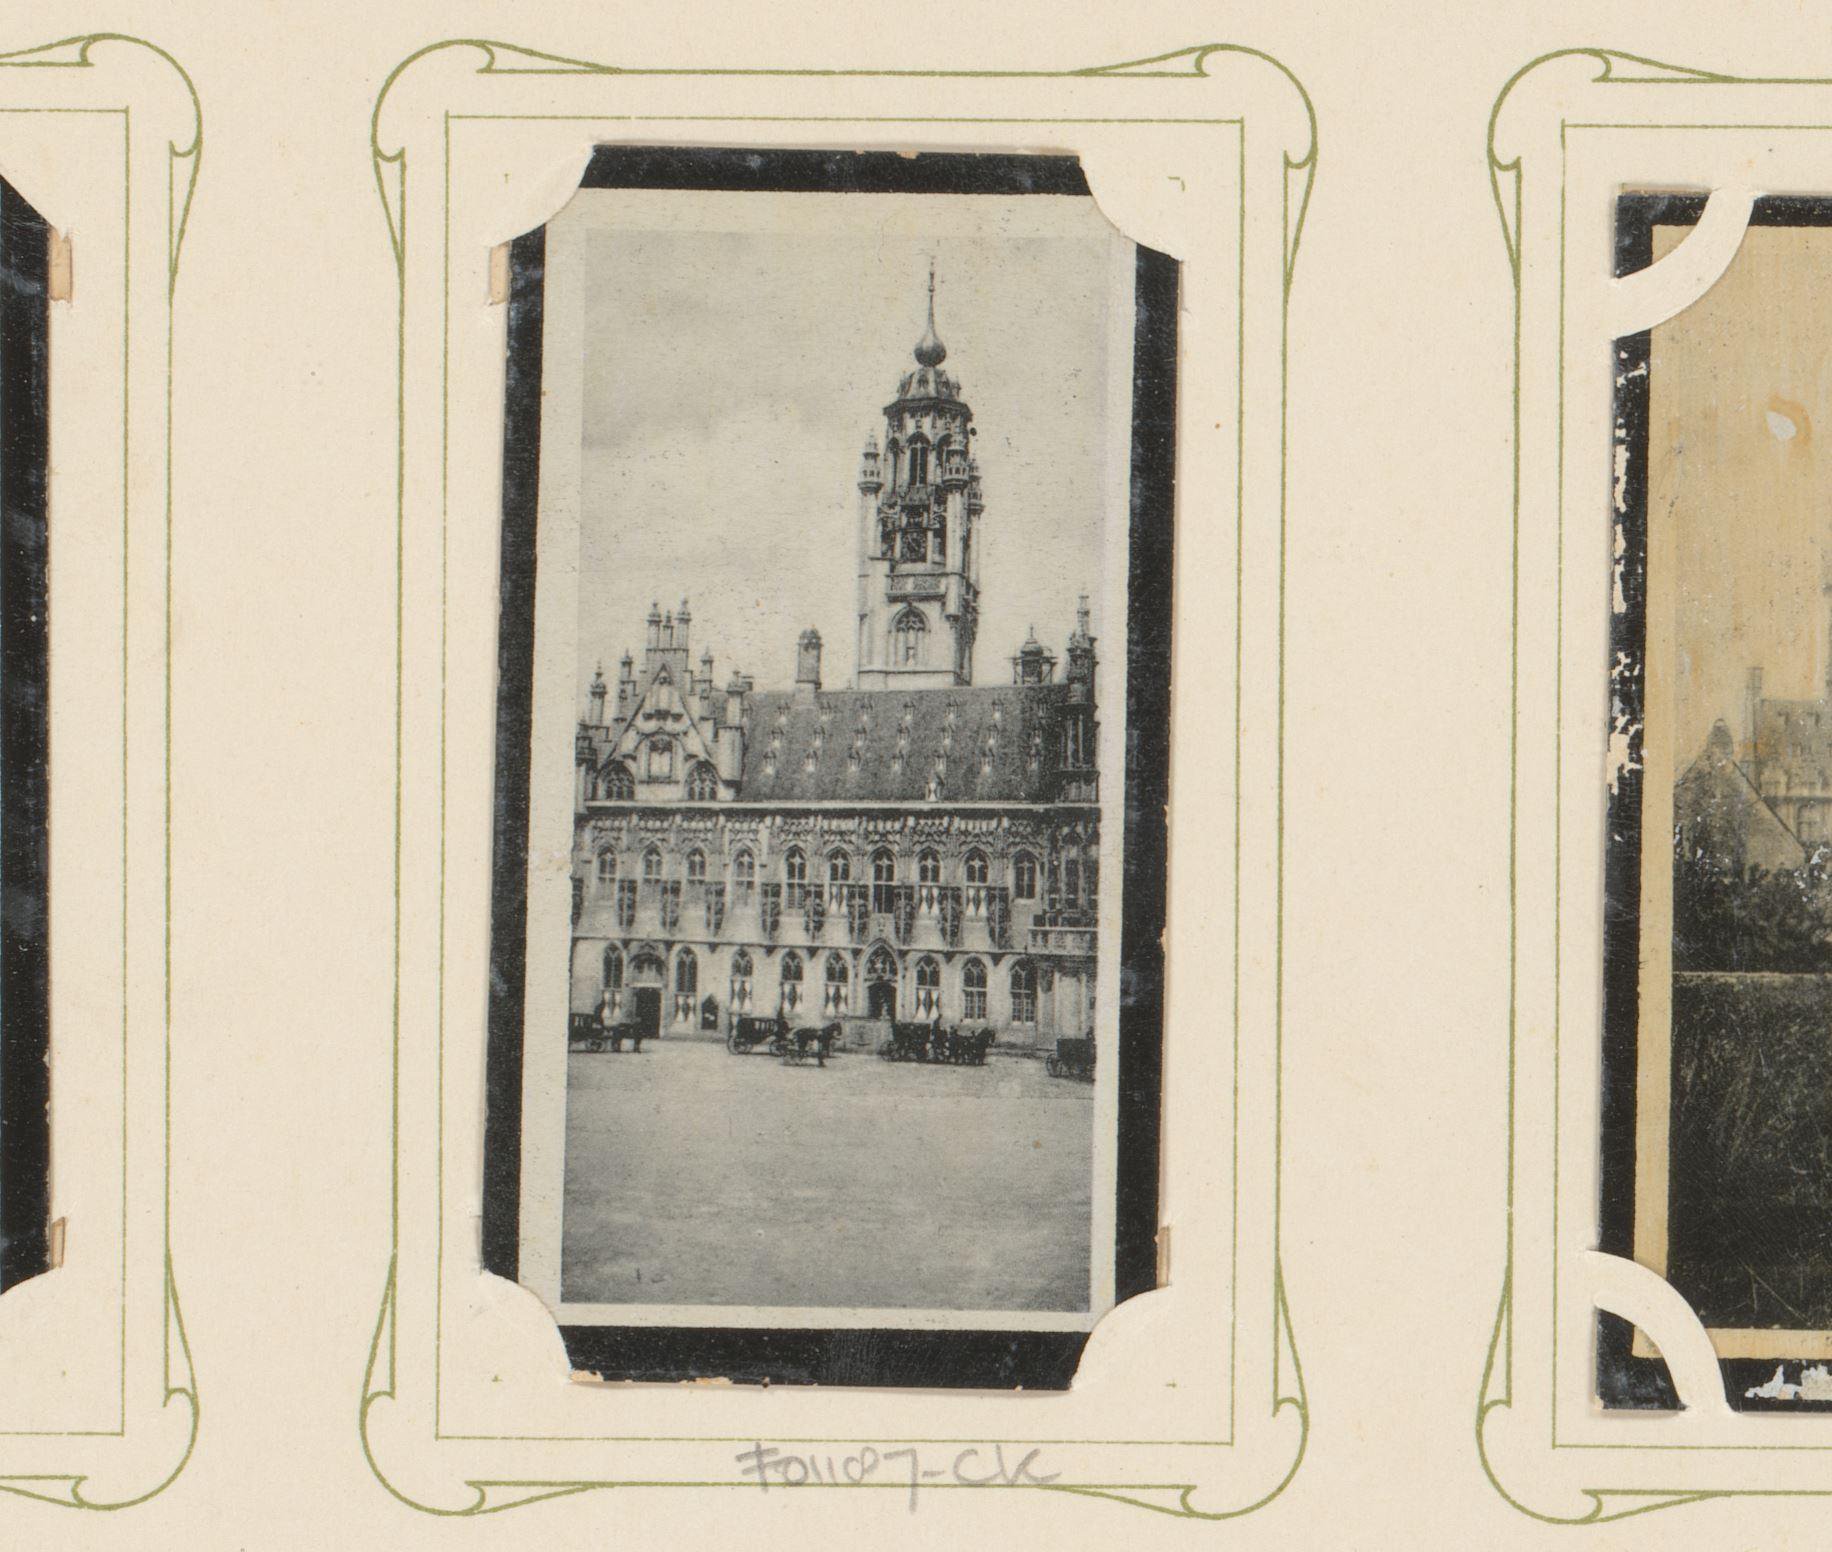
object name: photomechanical print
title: Gezicht op het stadhuis van Middelburg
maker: Anonymous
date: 1905-1906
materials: paper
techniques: photograph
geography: middelburg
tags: townhall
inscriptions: inscription: ‘No. 2./ Stadhuis te Middelburg.’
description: Deze prent maakt deel uit van een album.